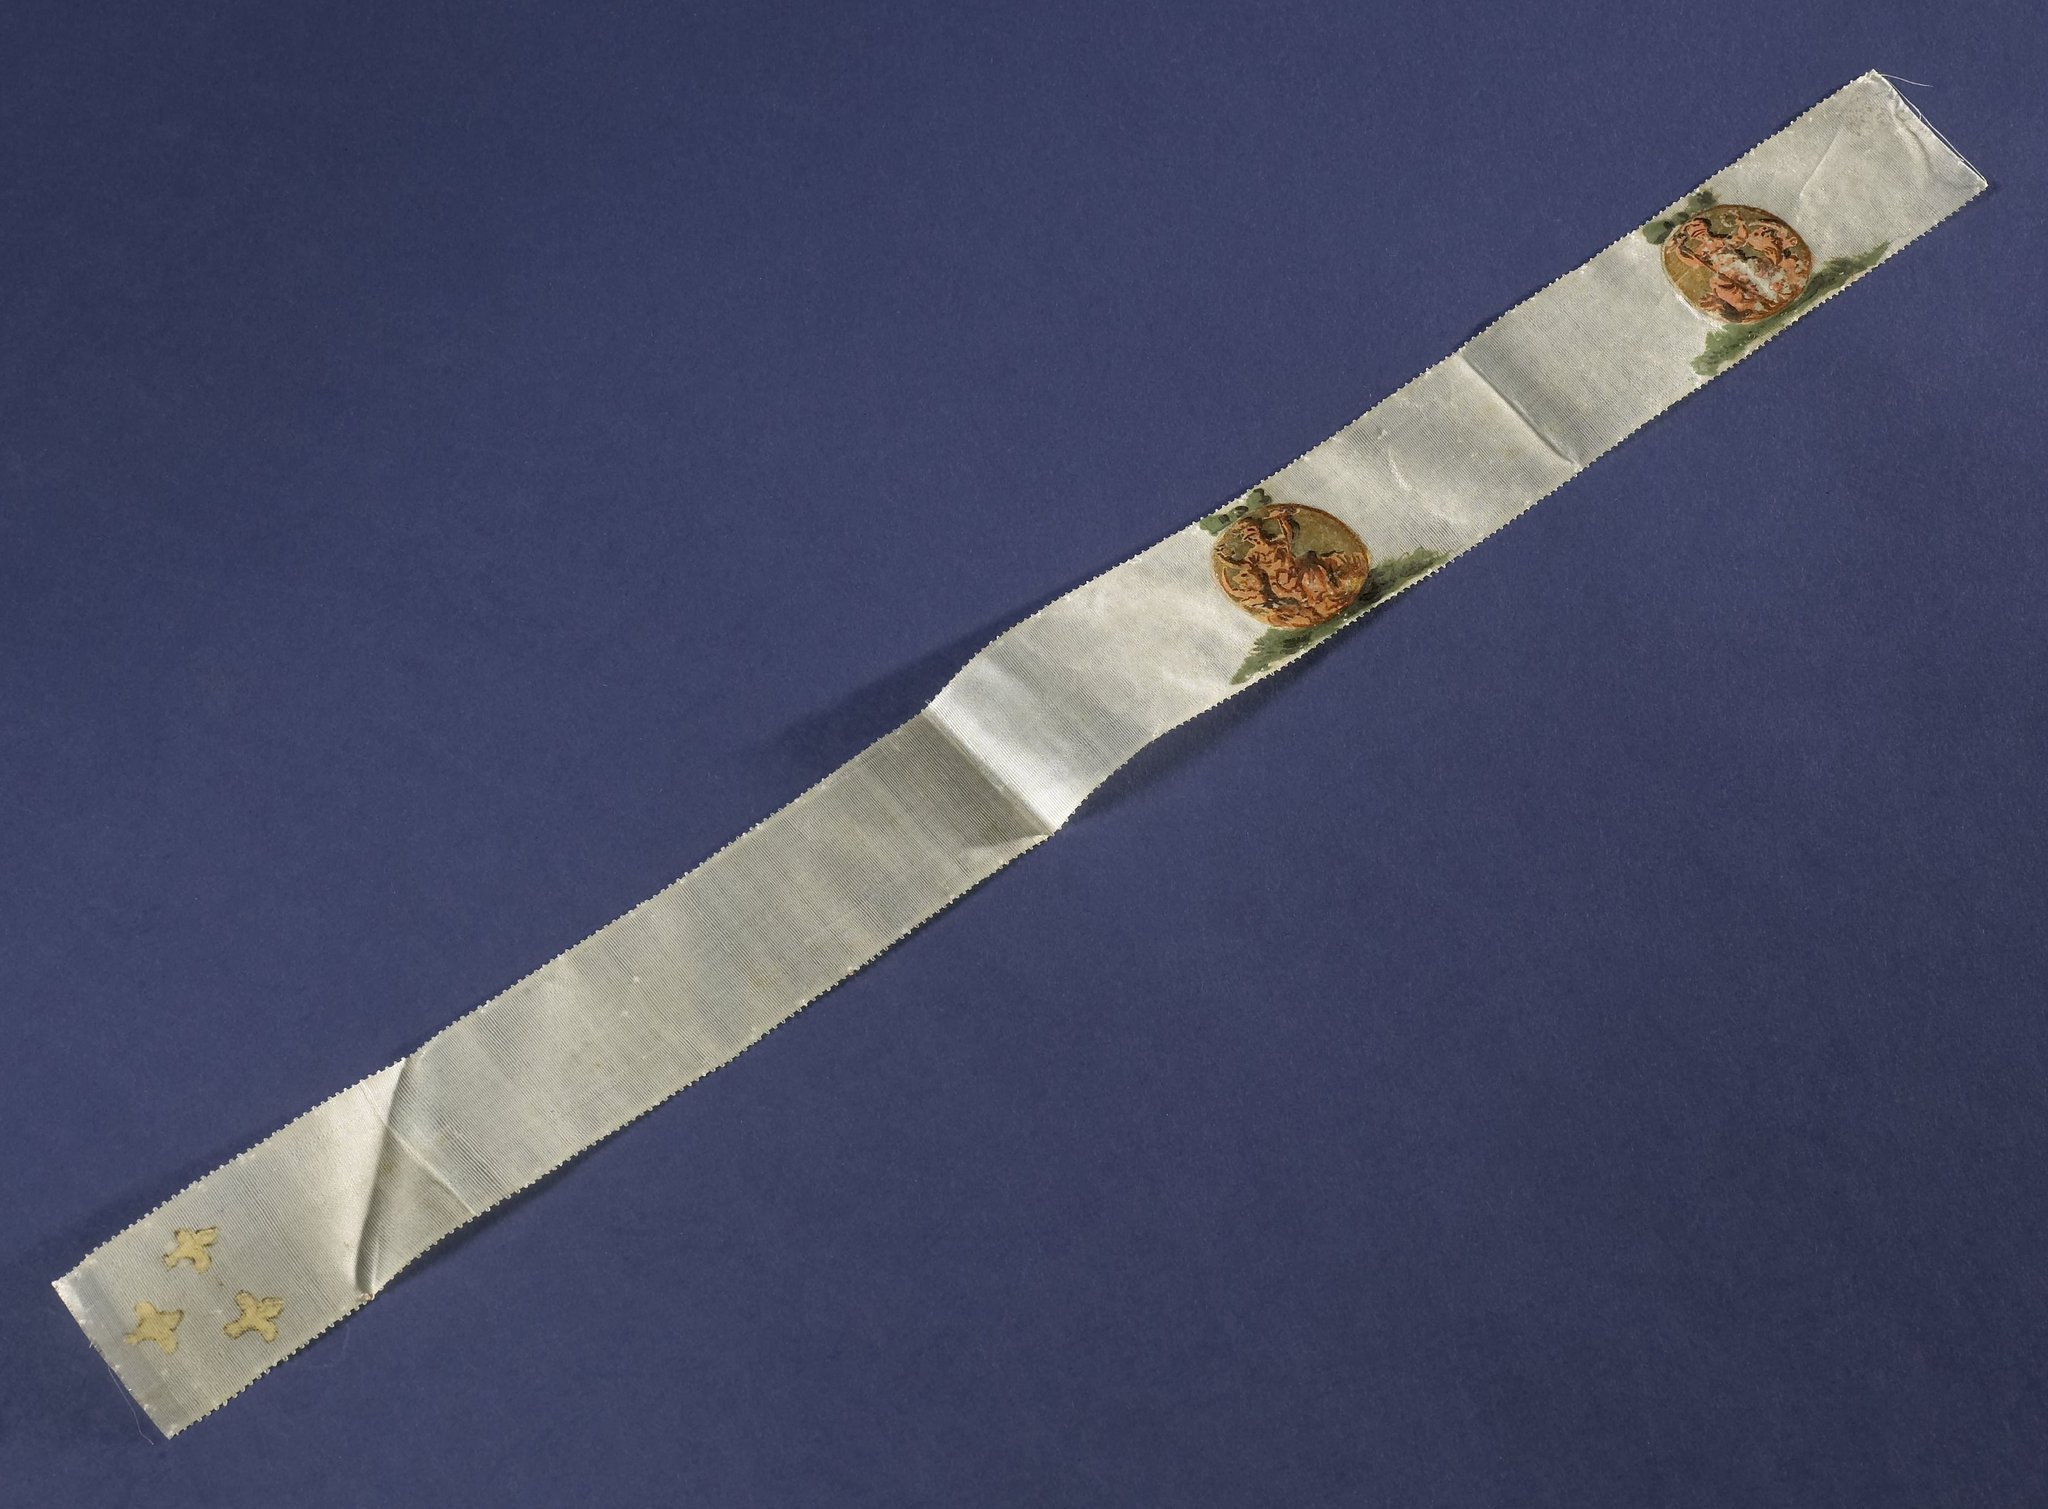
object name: ribbon material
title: Patriottenlint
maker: Anonymous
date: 1775-1800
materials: silk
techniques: printing, weave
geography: netherlands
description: Lint met links een drietal zgn. Franse lelies en rechts een tweetal goudkleurige imitaties van penningen. Op de 'penningen' is een zittende vrouw (vrijheidsmaagd) weergegeven. Aan de bovenkant is een strik afgebeeld en aan de onderkant een groenstrook.